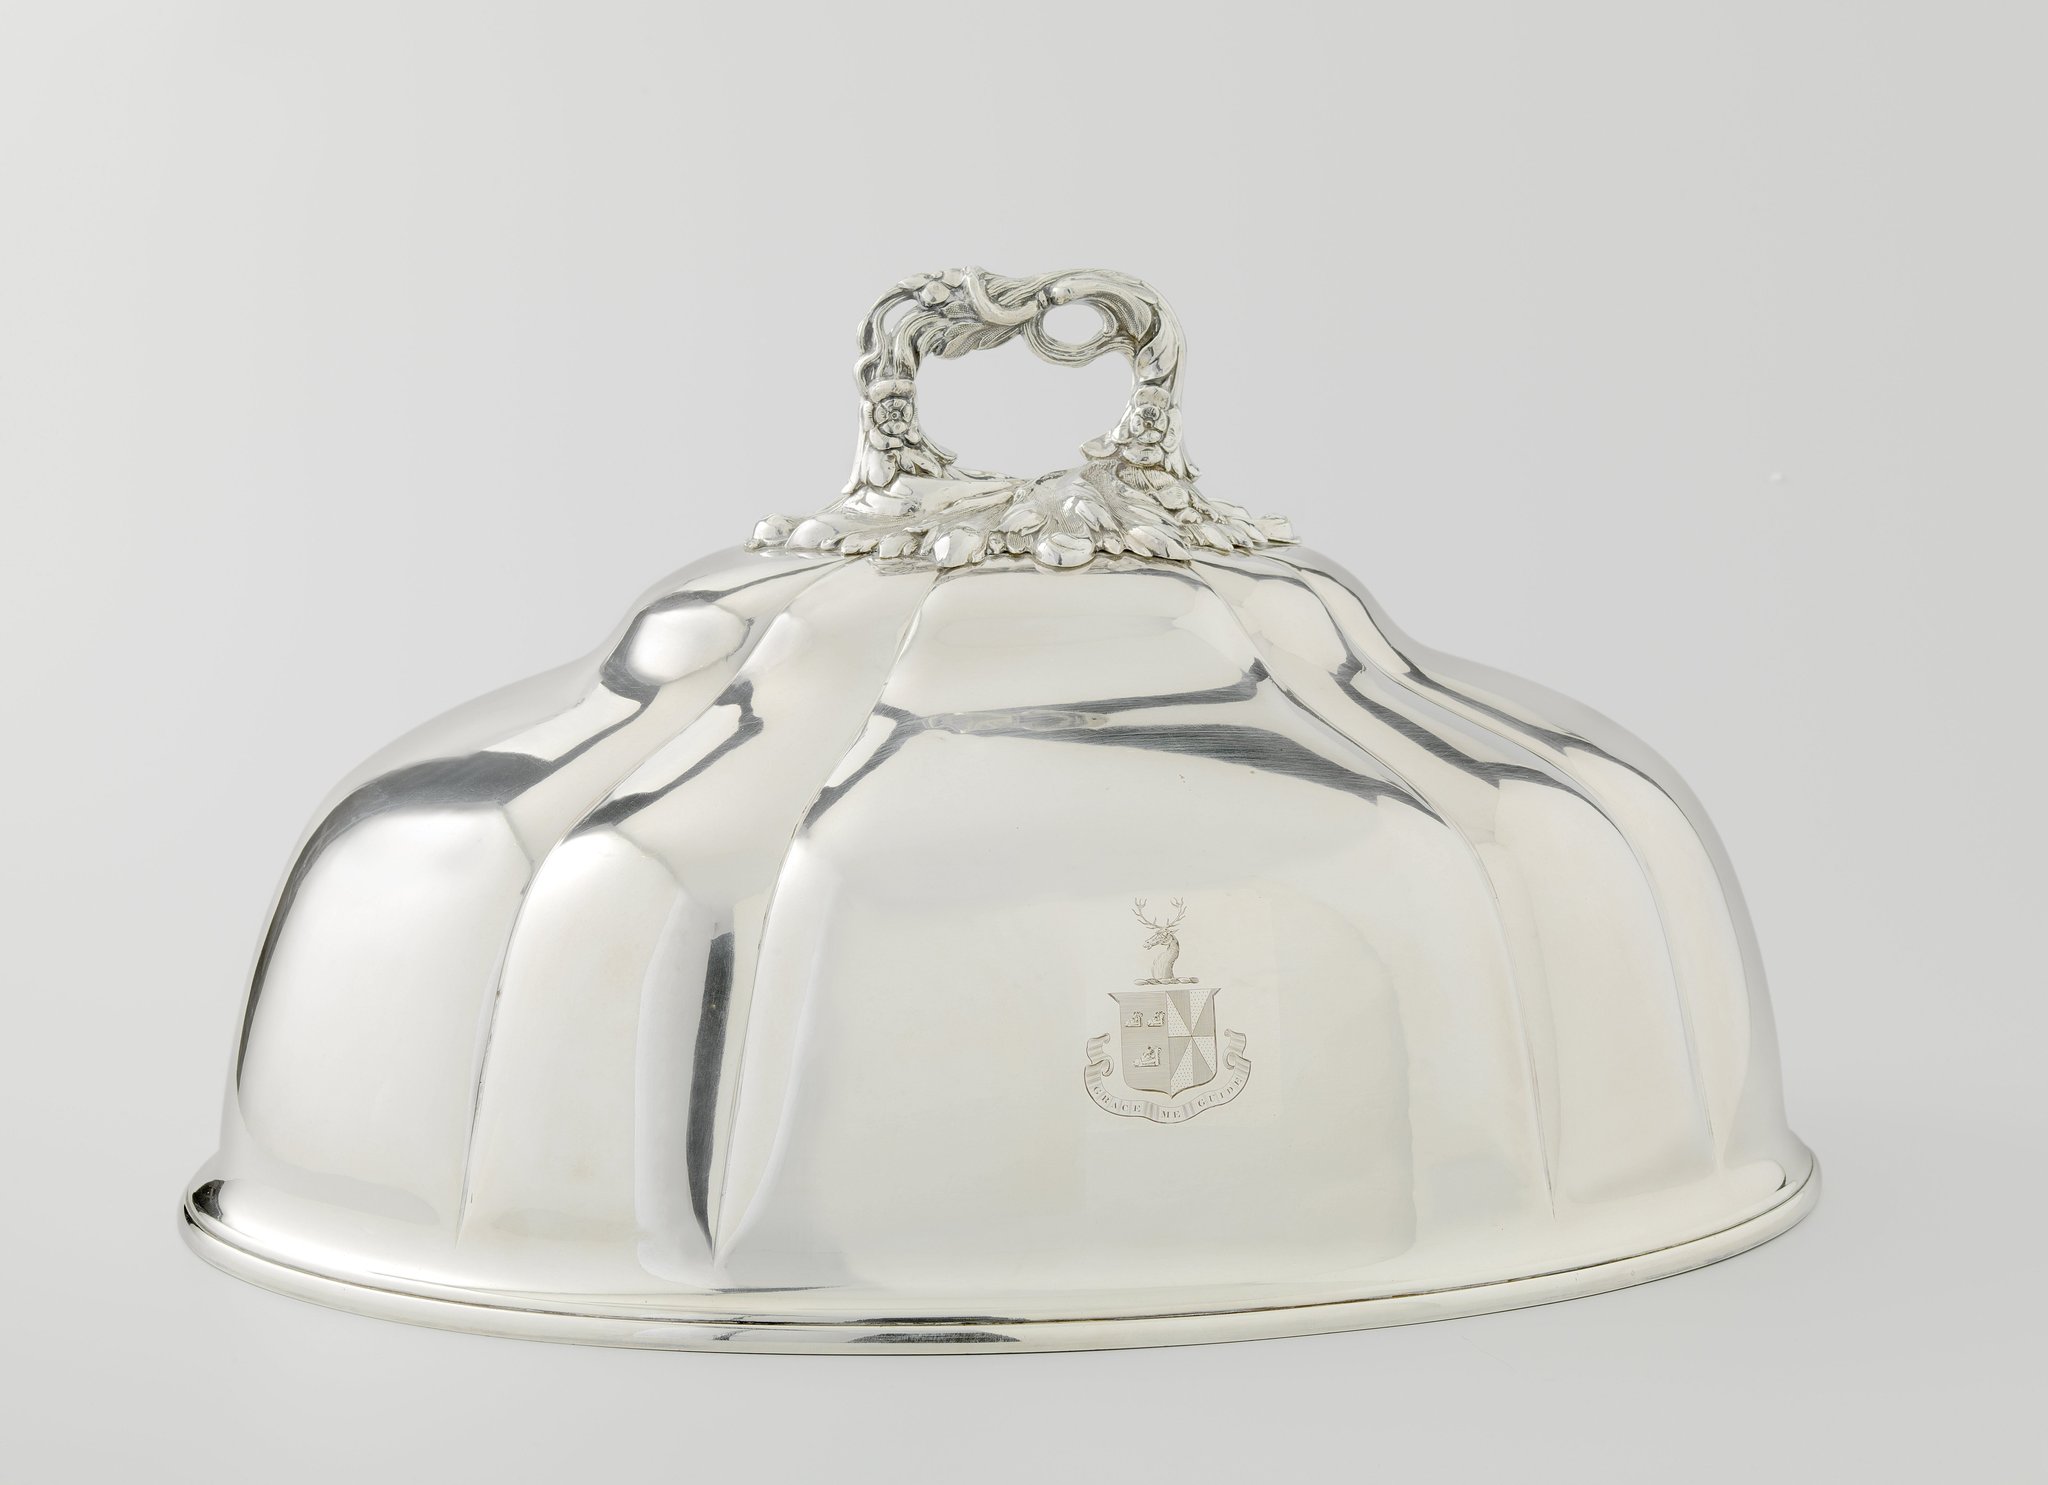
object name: lid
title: Deksel van zilver, ovaal en koepelvormig, met handvat van bloem- en bladmotieven. Gegraveerd alliantiewapen met hert en wapenspreuk: Grace me guide.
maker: Anonymous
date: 1870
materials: silver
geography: sheffield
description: Grote, ovale deksel van zilver, voor het warmhouden van spijzen. Koepelvormig met een handvat uit barokke bloem- en bladmotieven. Een gegraveerd alliantiewapen met een hert als crest. Daaronder de wapenspreuk: Grace me guide.